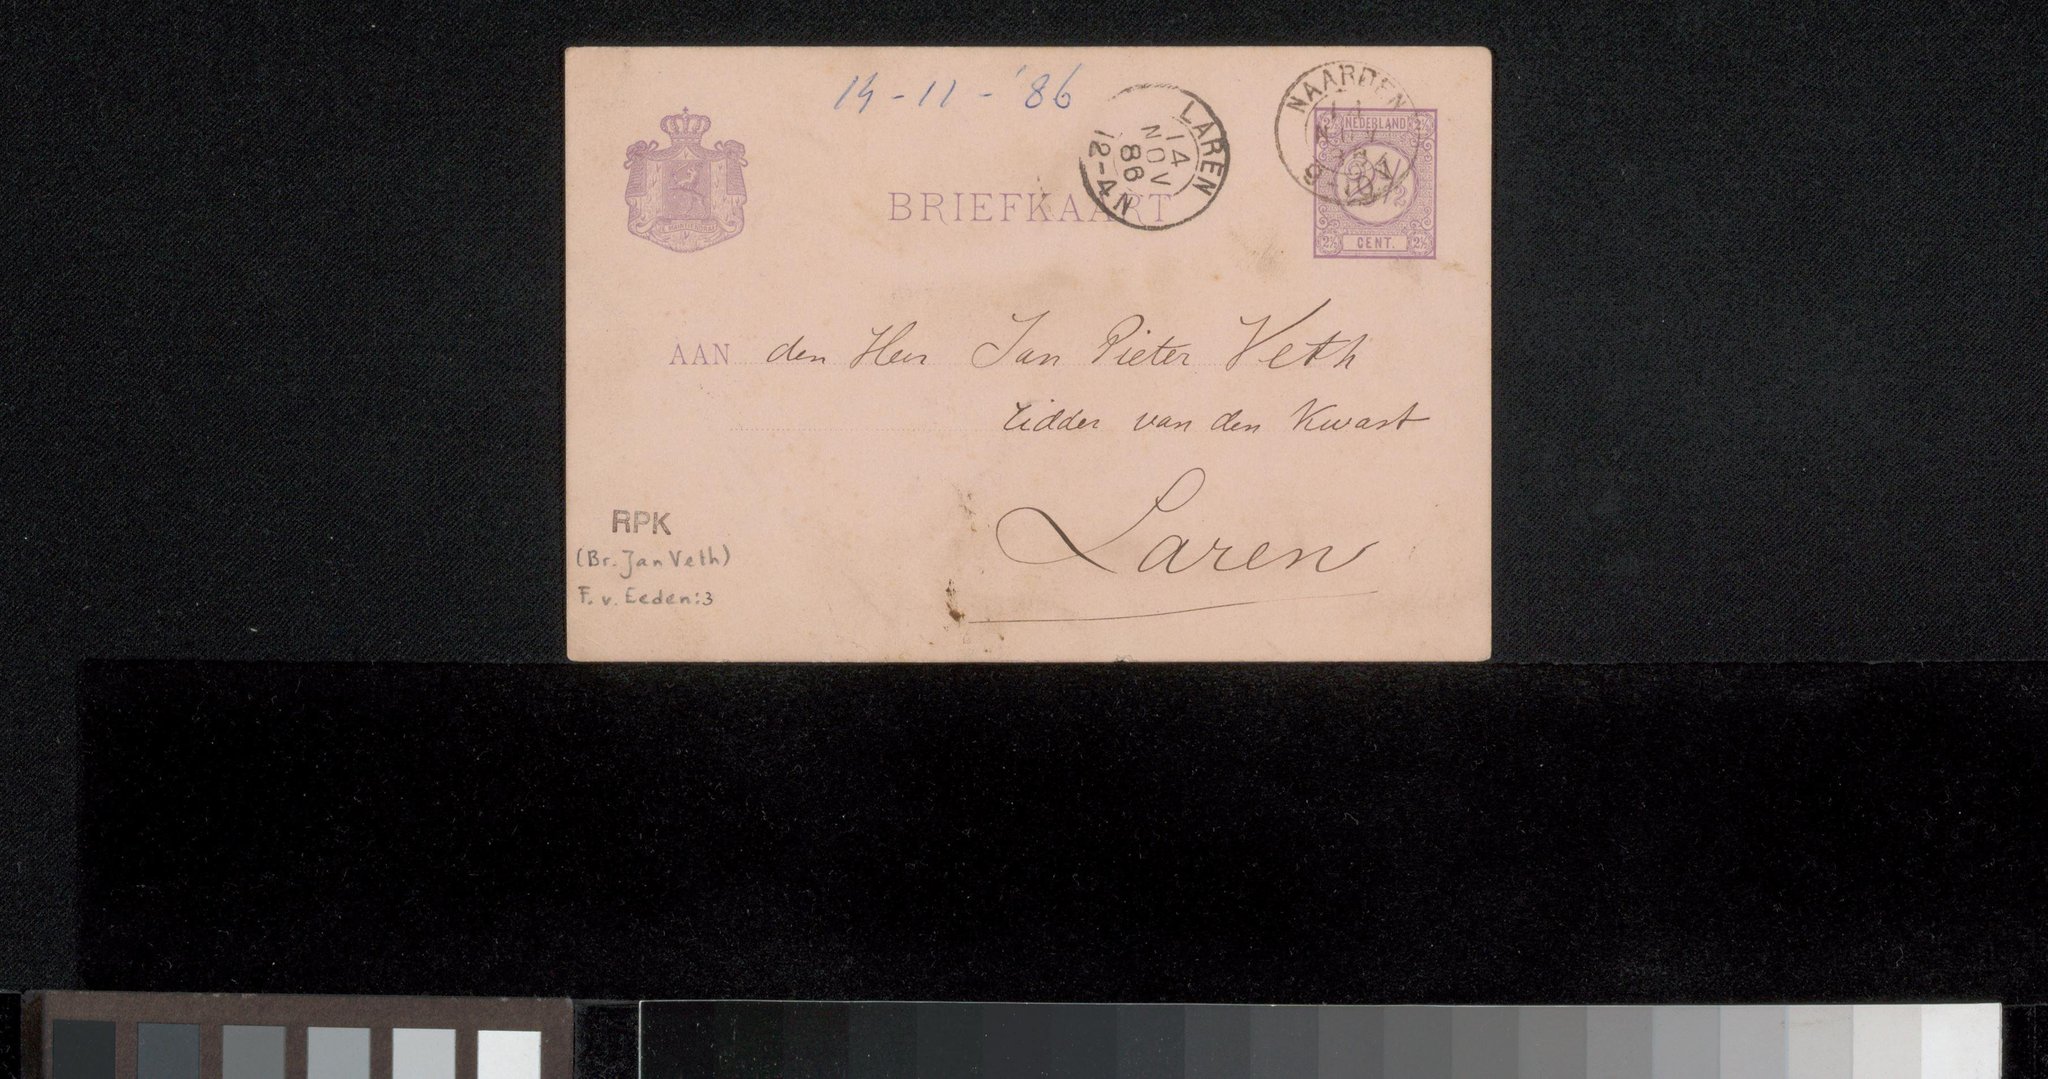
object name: postcard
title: Briefkaart aan Jan Veth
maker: frederik van eeden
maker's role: schrijver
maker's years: 1860-1932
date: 1886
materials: cardboard, ink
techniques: pen, writing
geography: naarden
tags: dordrecht, amsterdam, painter, print maker, draughtsman, designer, jan veth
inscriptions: collector's mark: ‘RPK’